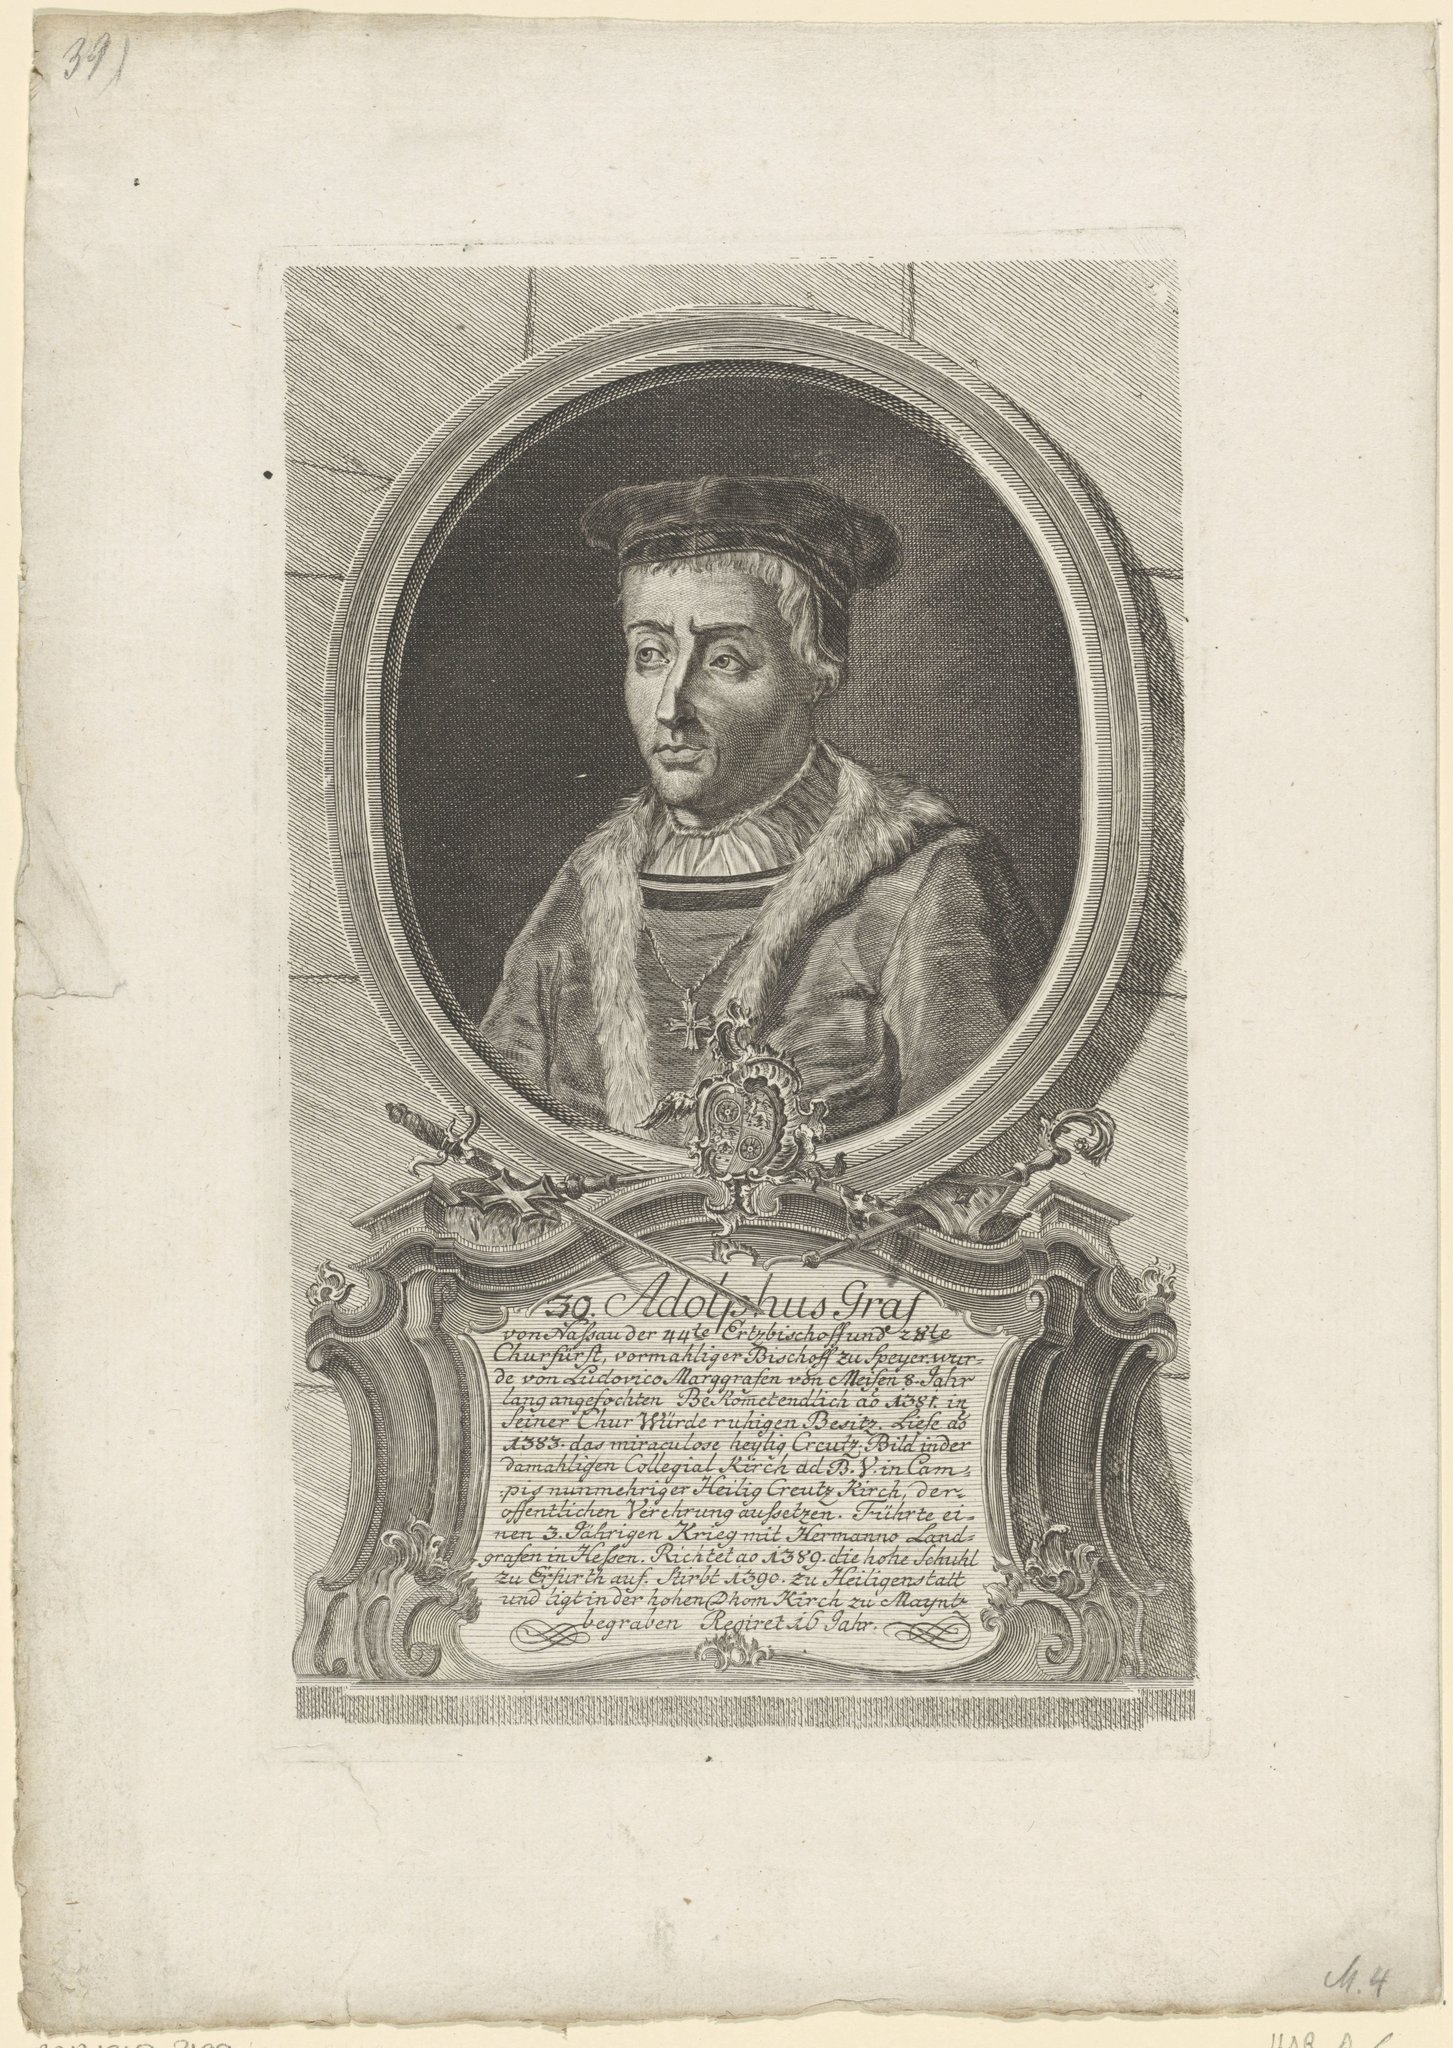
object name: print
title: Portret van Adolf van Nassau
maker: Anonymous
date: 1600-1699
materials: paper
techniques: engraving, etching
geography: germany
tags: heiligenstadt, adolf van nassau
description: Portret van Adolf in een ovaal. Daar omheen een aantal allegorische objecten. Midden onder zijn wapen. Op een voetstuk vijftien regels Duitse tekst.